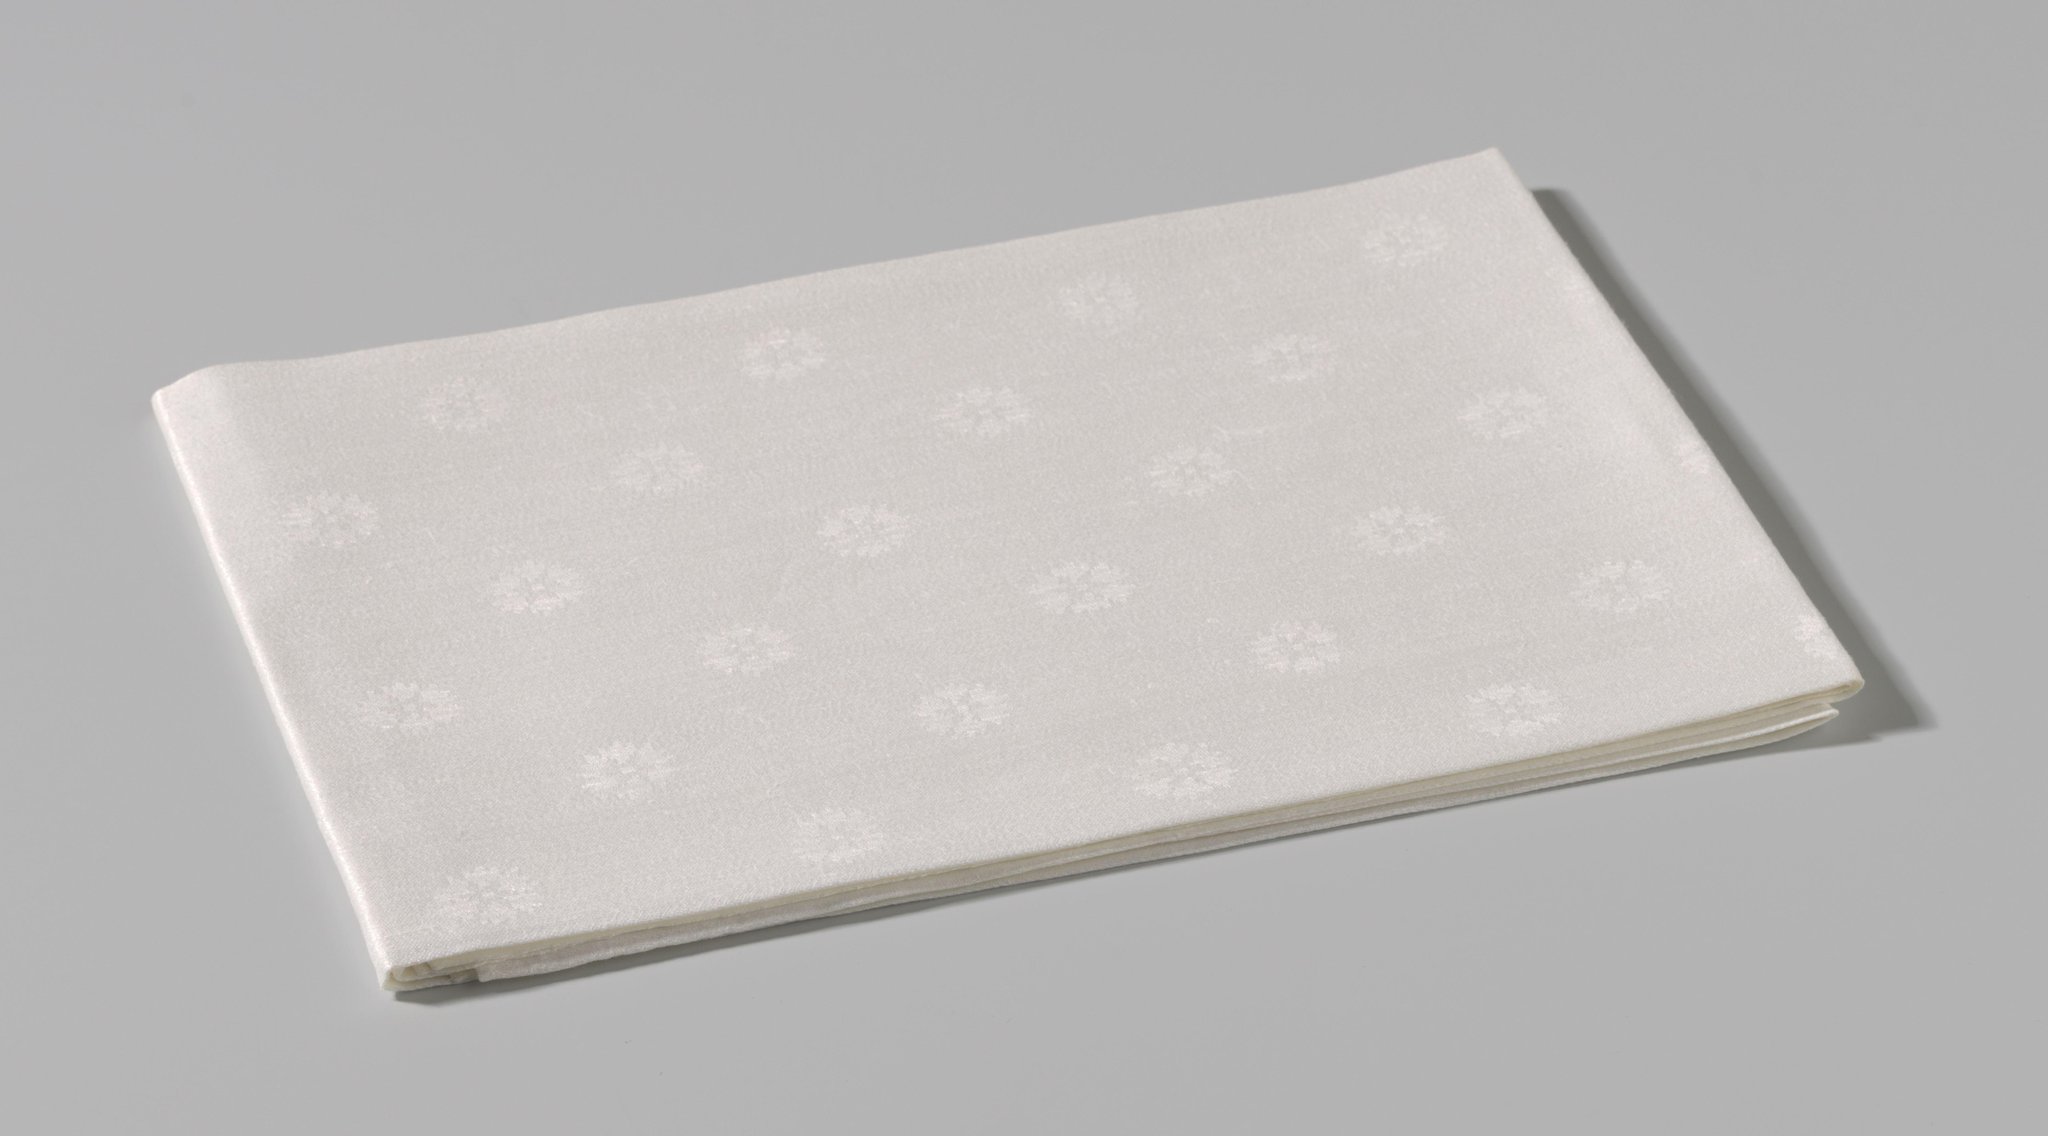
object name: napkin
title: Servet met een bloempatroon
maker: Anonymous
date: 1800-1810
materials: linen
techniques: damask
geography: western europe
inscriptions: mark: ‘ME’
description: Servet van linnendamast met een bloempatroon. Verspringende rijen van rozetten. Brede rand van spiraalsgewijs een middenstam omvattende tweezijdig gevederde bladranken. Vallend blaadje als vulling. Gelijke binnen- en buitenzoom van aaneengeschakelde cirkels. Rondom: blokkenrand. De bladranken van de servetten zijn niet identiek aan die van het tafellaken.